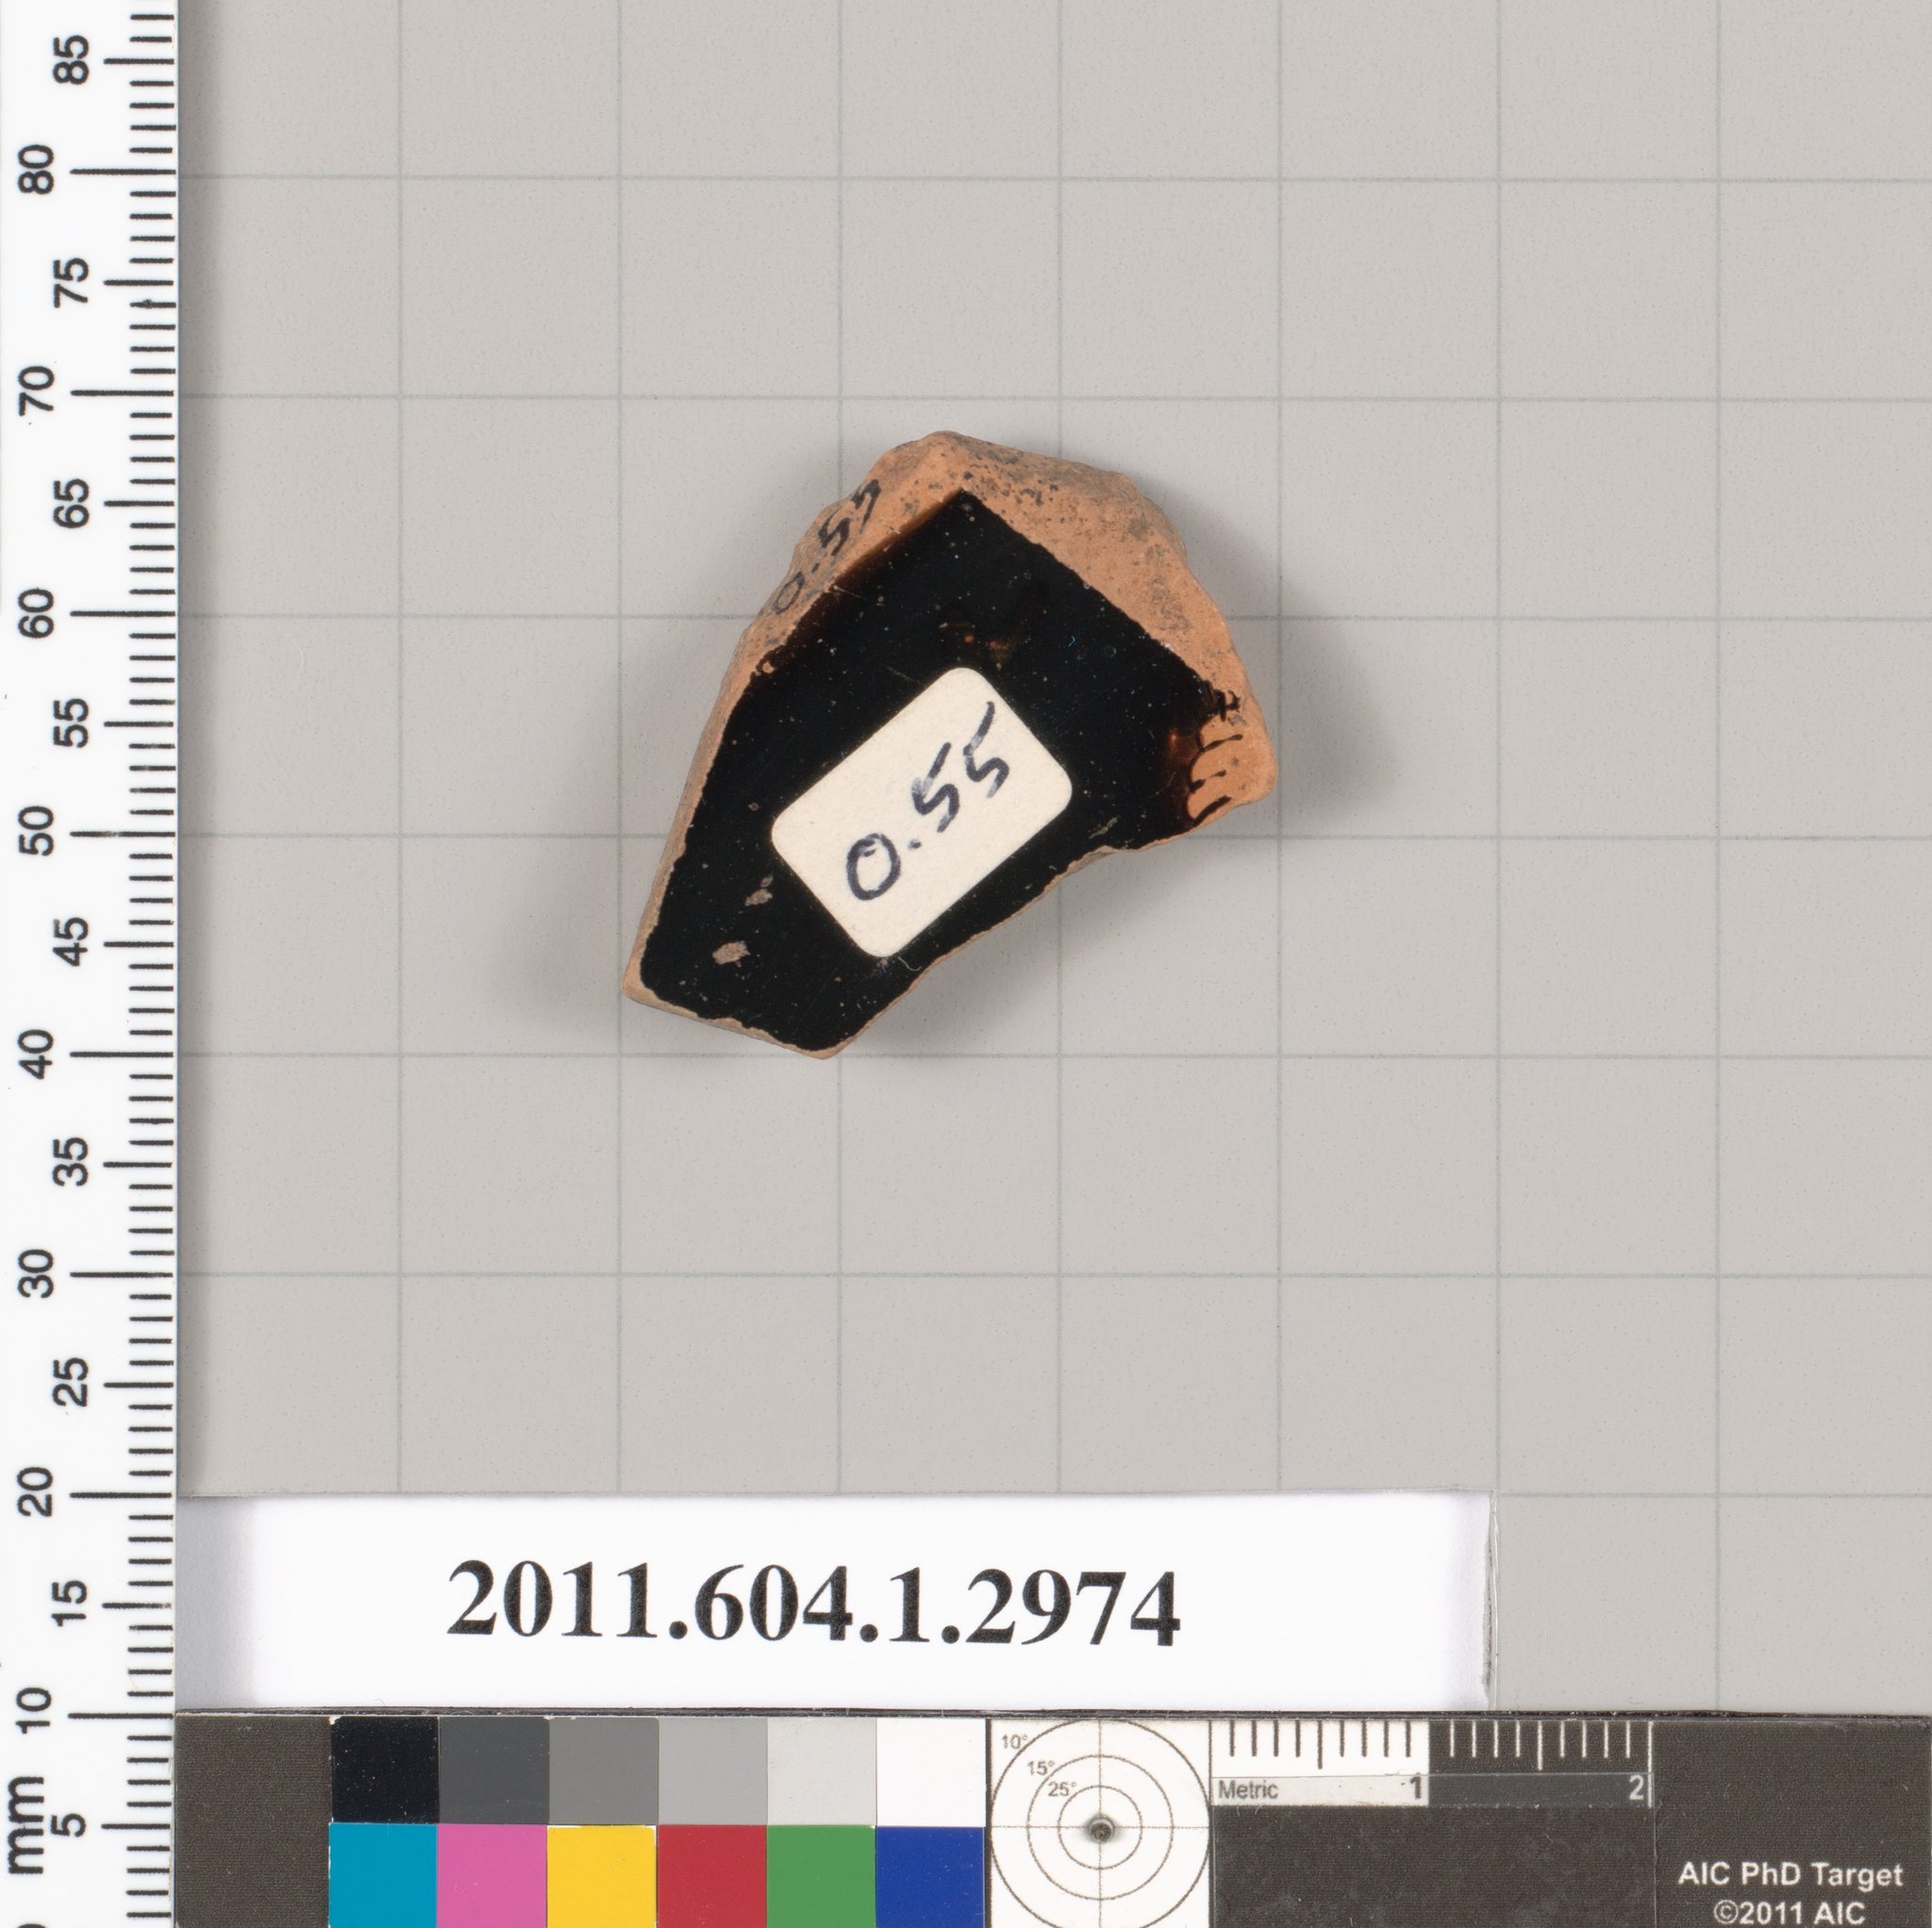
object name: kylix fragment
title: Terracotta fragment of a kylix (drinking cup)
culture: greek, attic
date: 500-476 BCE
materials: terracotta